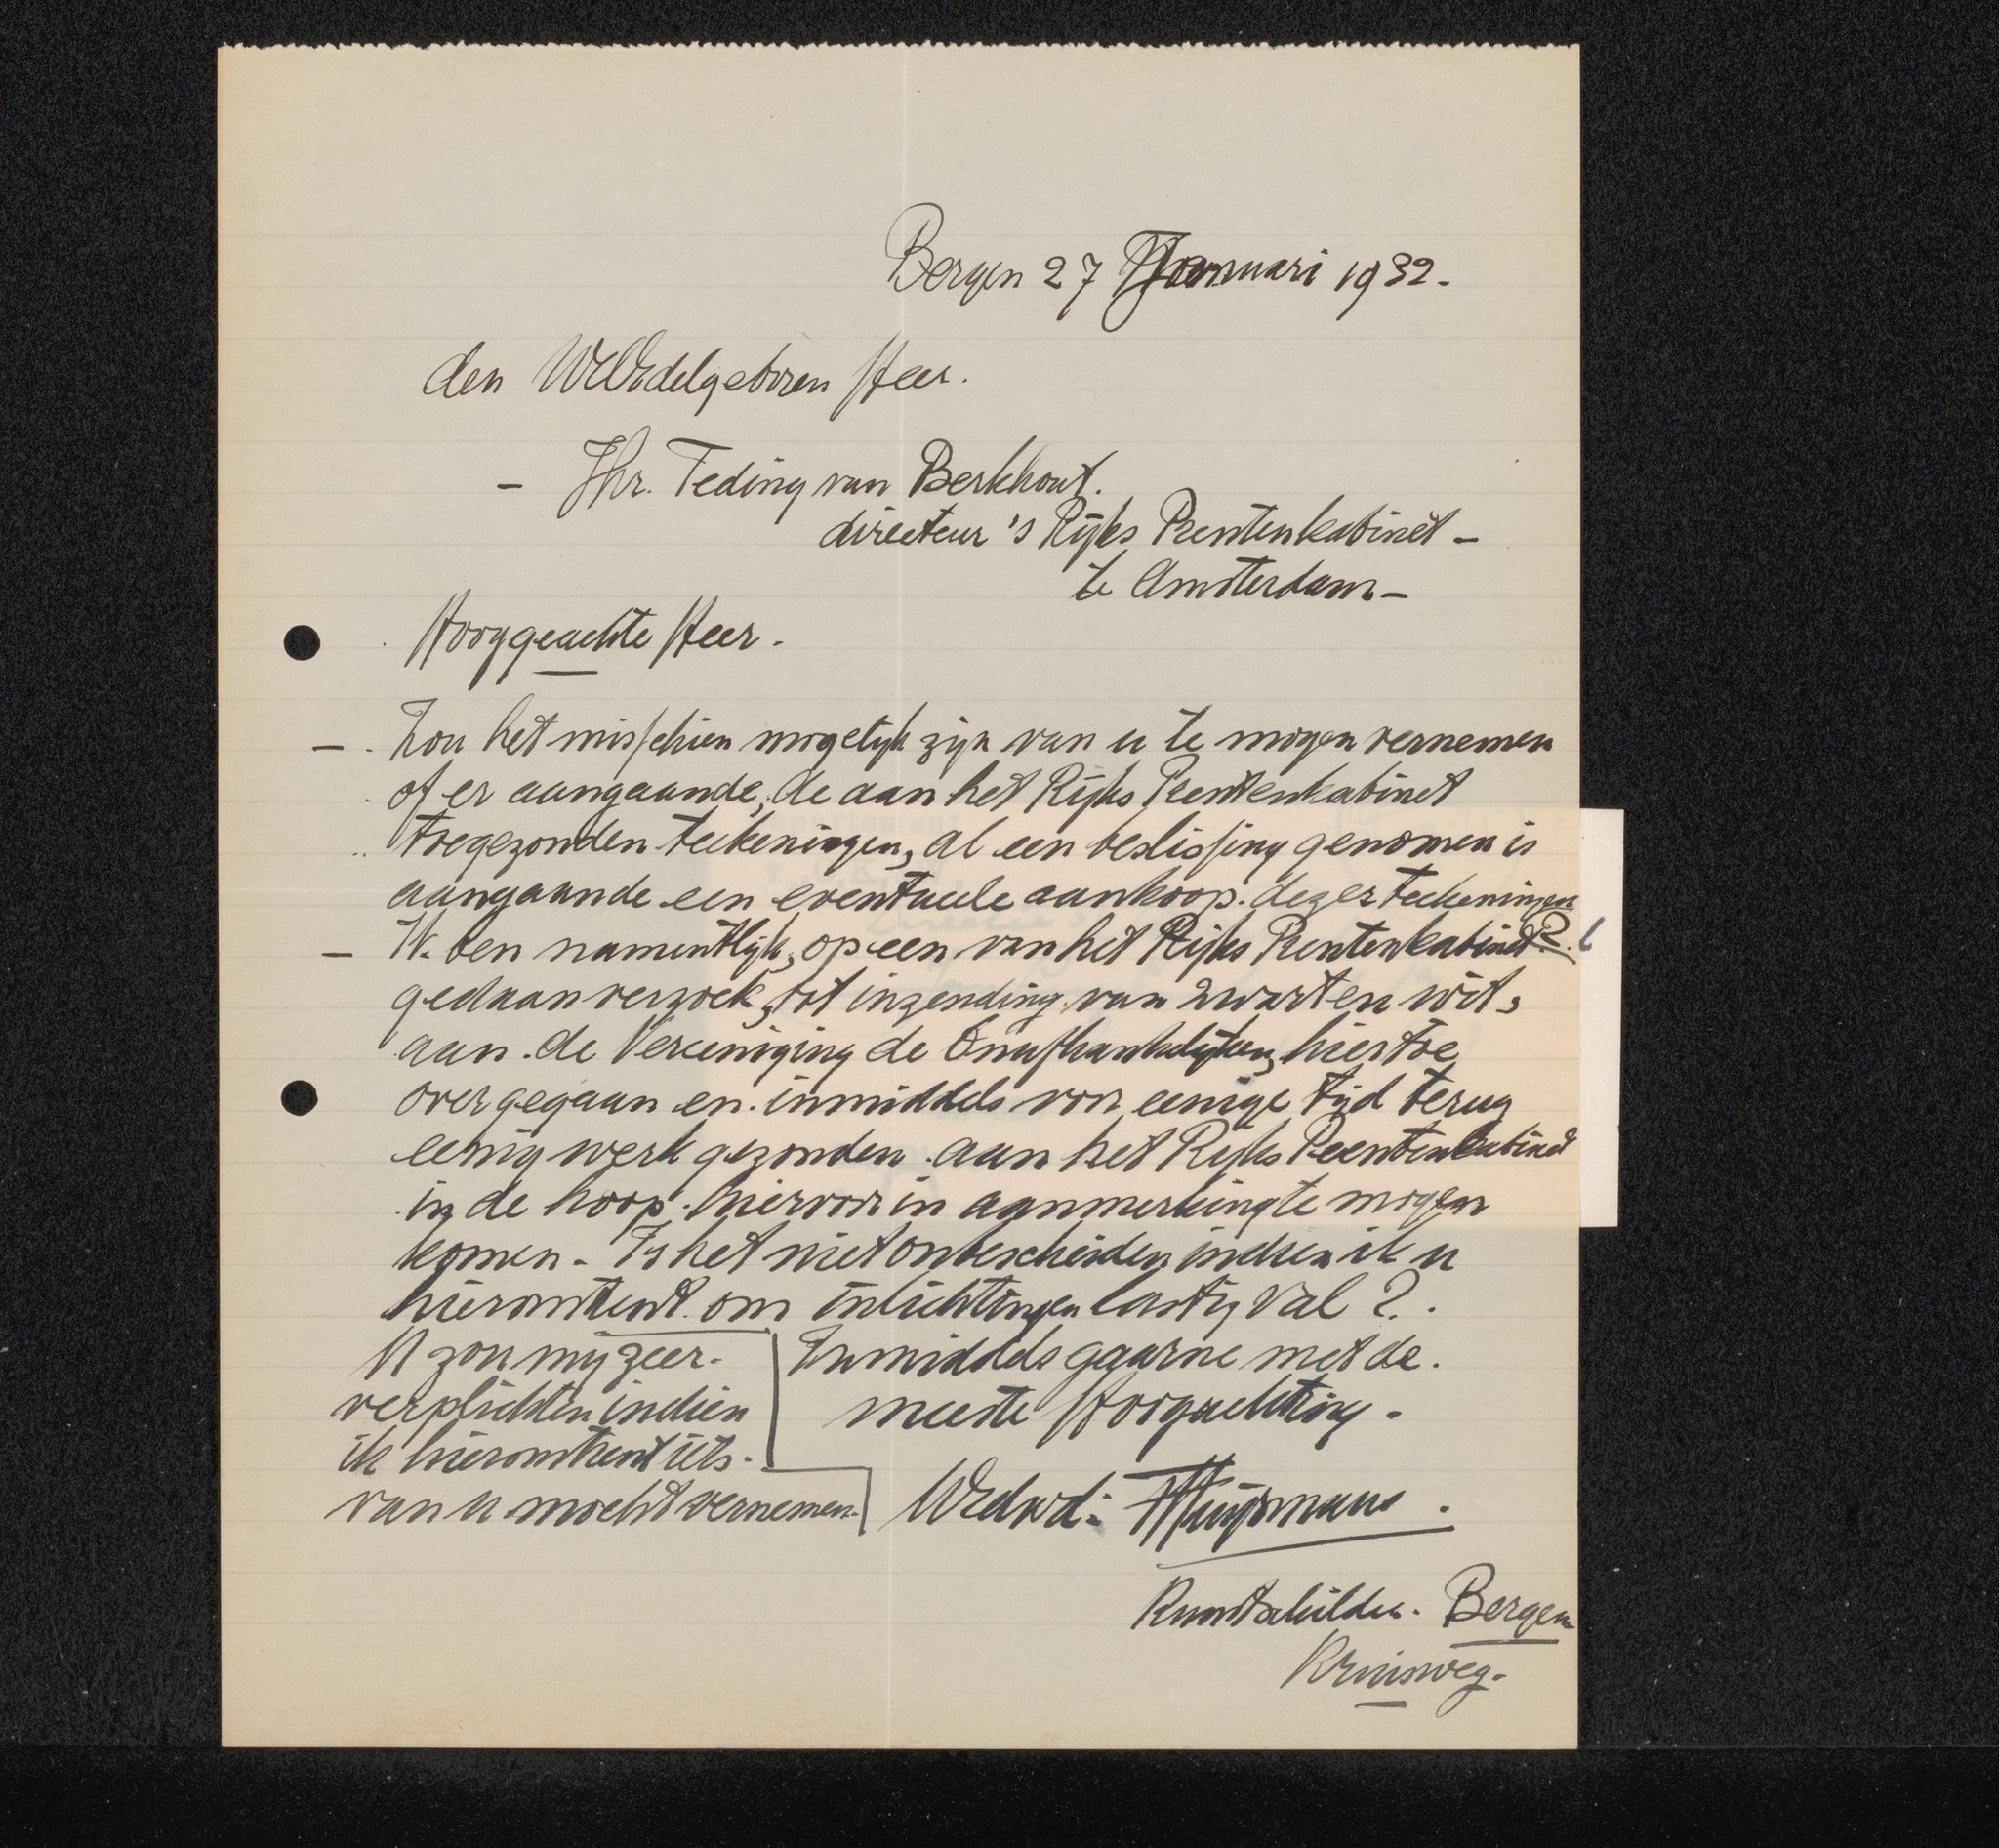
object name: letter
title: Brief aan jonkheer Hendrik Teding van Berkhout (1879-1969)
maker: frans huysmans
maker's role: draughtsman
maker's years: 1885-1954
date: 1932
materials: ink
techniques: pen, writing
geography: bergen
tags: print room, haarlem, amsterdam, jonkheer hendrik teding van berkhout (1879-1969), drawing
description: Brief bevat briefkaart betreffende teruggezonden werken.